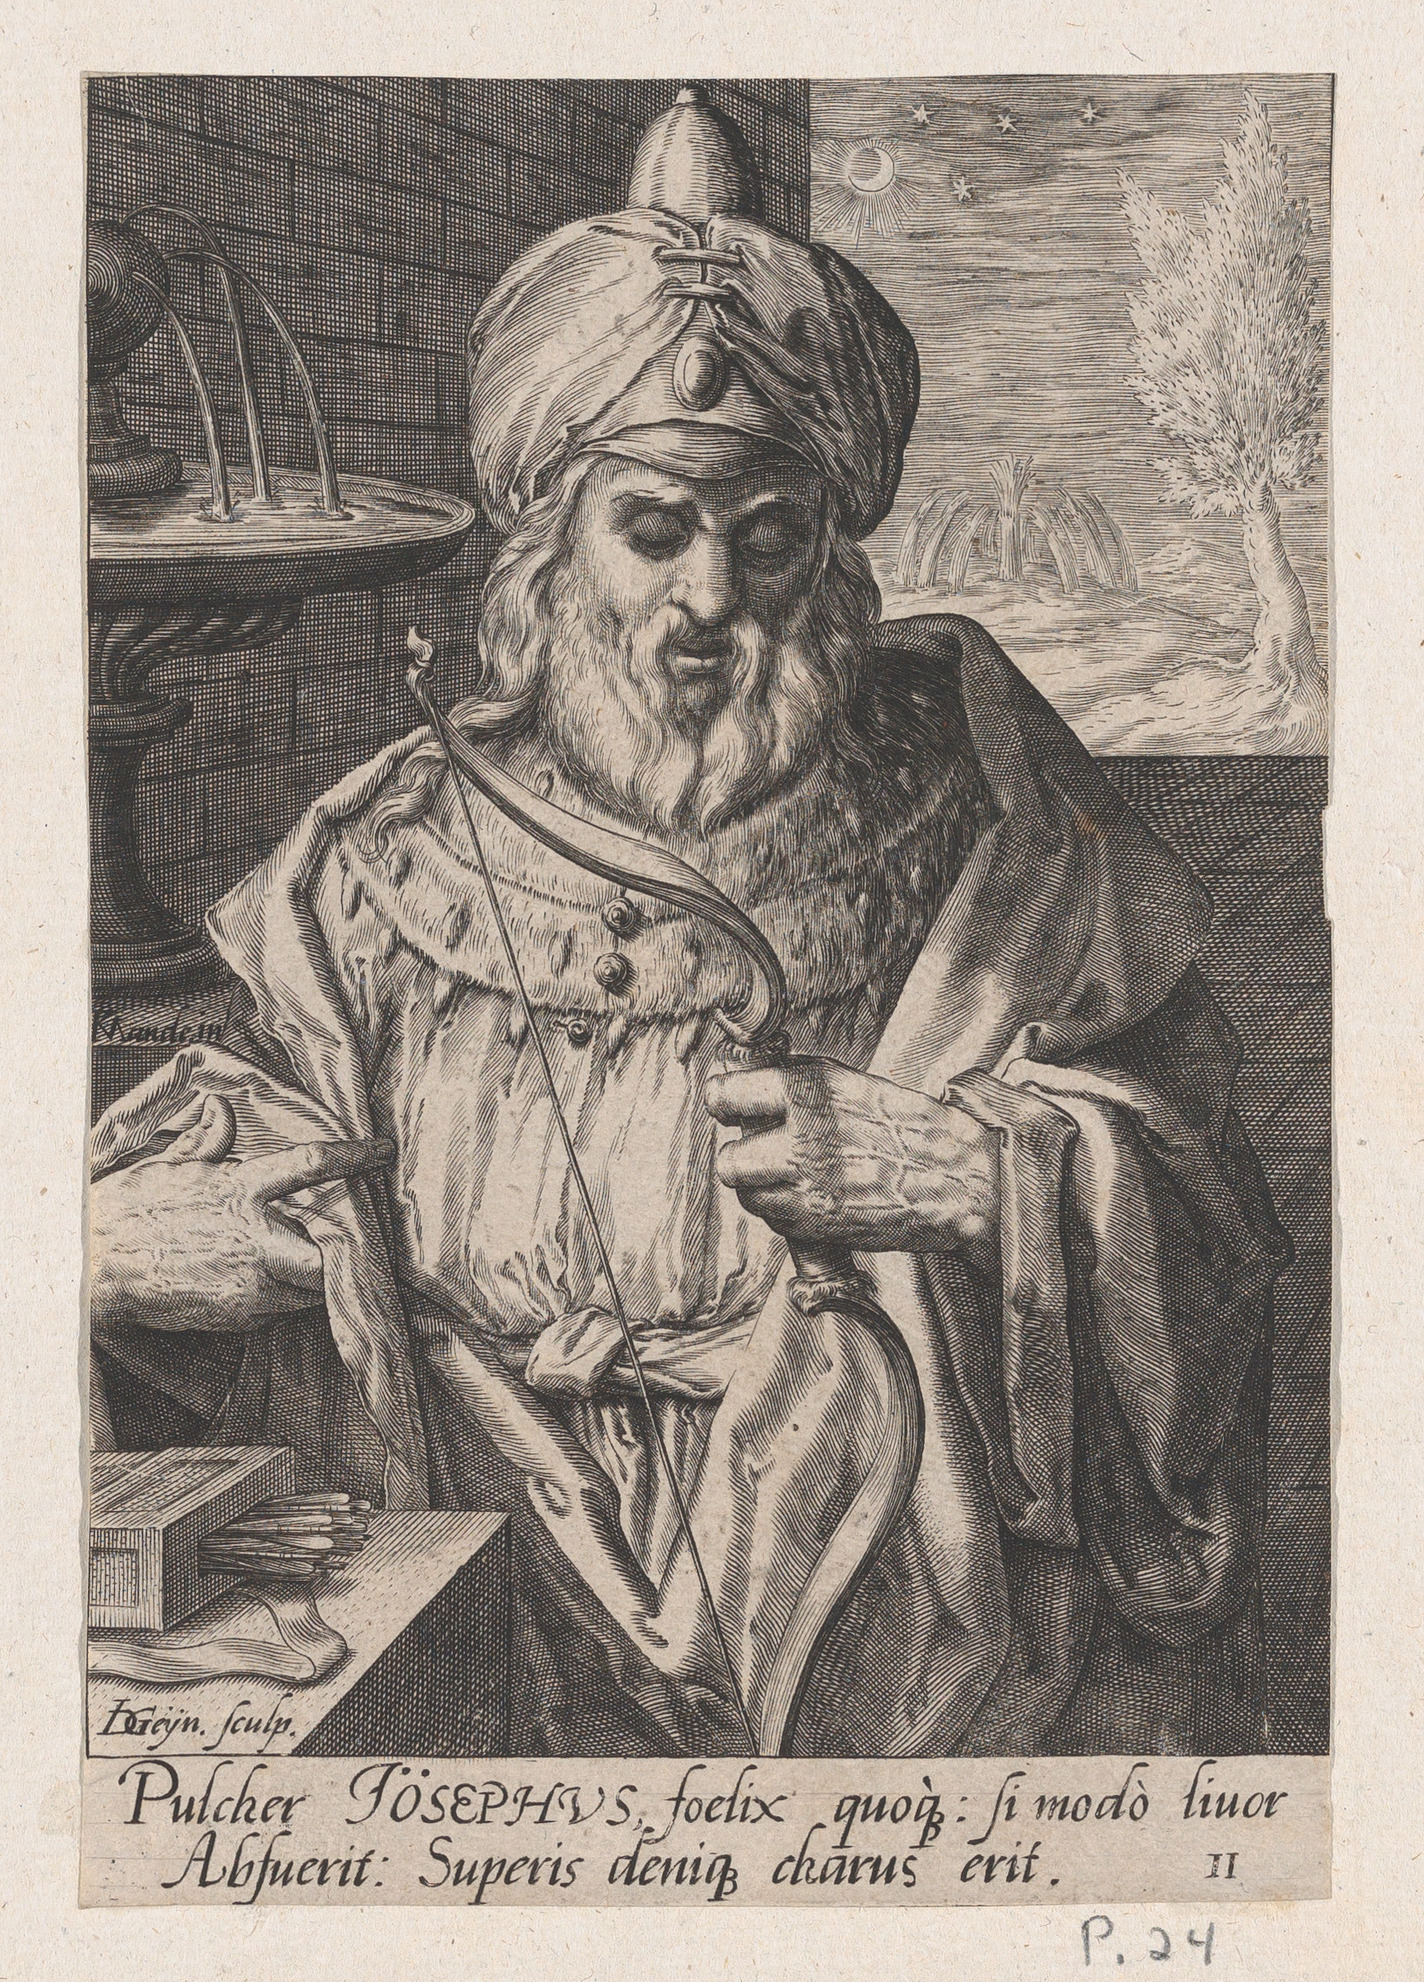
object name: print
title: Joseph, from The Twelve Sons of Jacob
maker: jacques de gheyn (ii)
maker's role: artist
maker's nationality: netherlandish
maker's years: 1565-1629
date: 1584-1594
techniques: engraving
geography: amsterdam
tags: bow and arrow,men